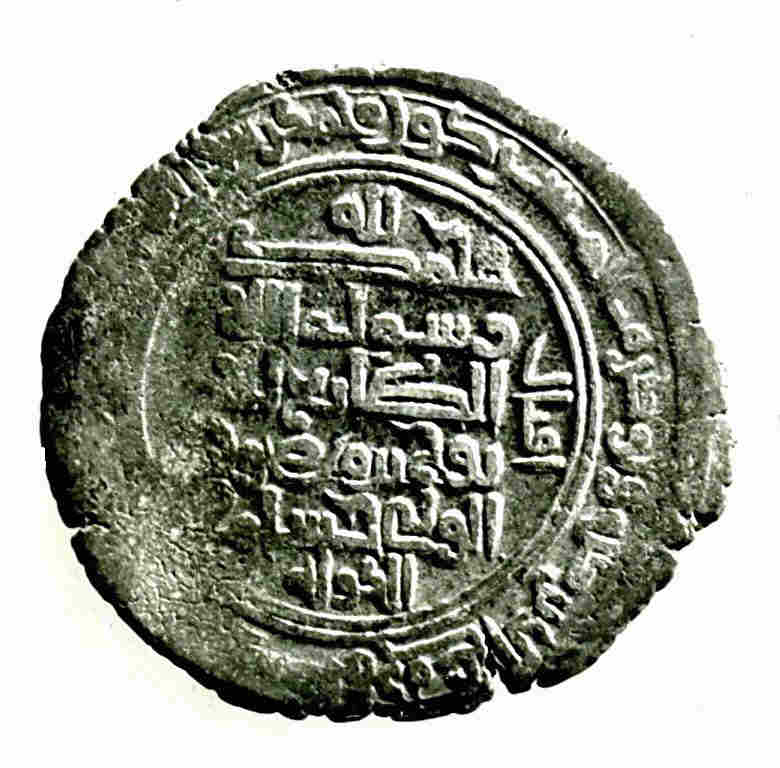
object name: coin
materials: silver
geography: iran